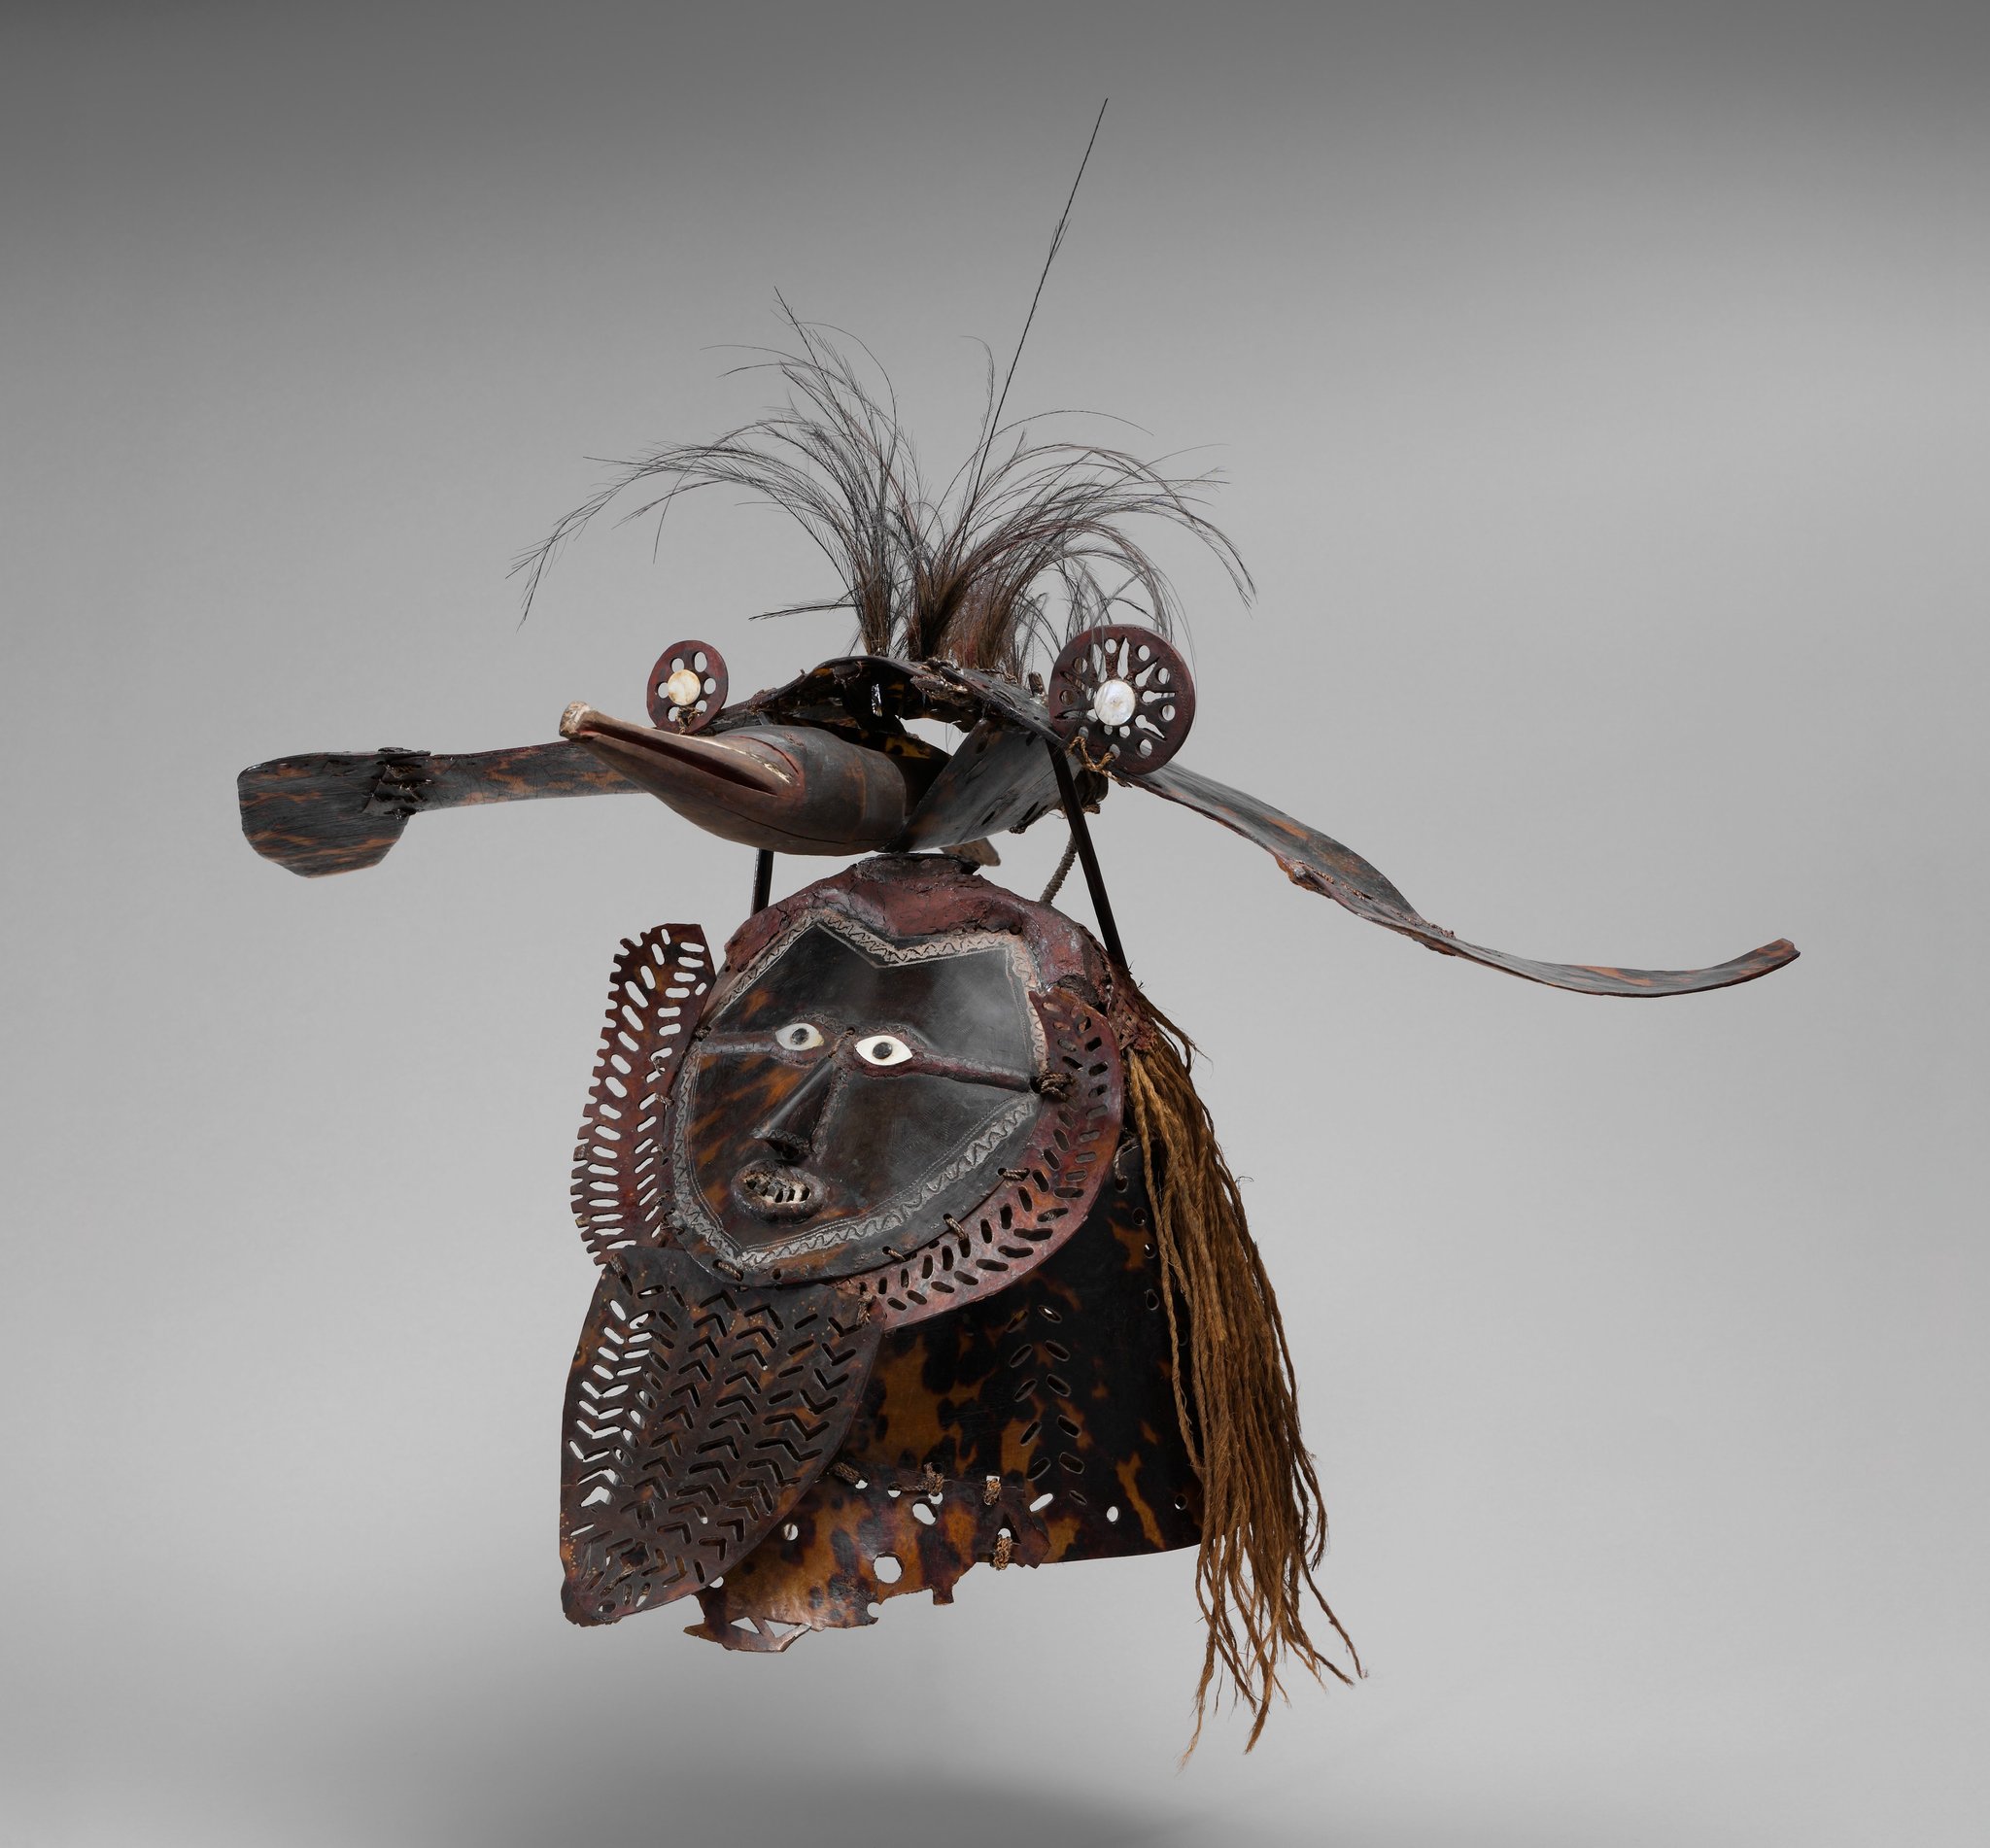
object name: mask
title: Mask (Buk, Krar, or Kara)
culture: torres strait islander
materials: feather, fiber, paint, shell, wood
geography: australia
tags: birds